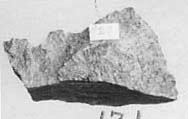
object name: fragment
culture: russian, siberia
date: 1902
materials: jade